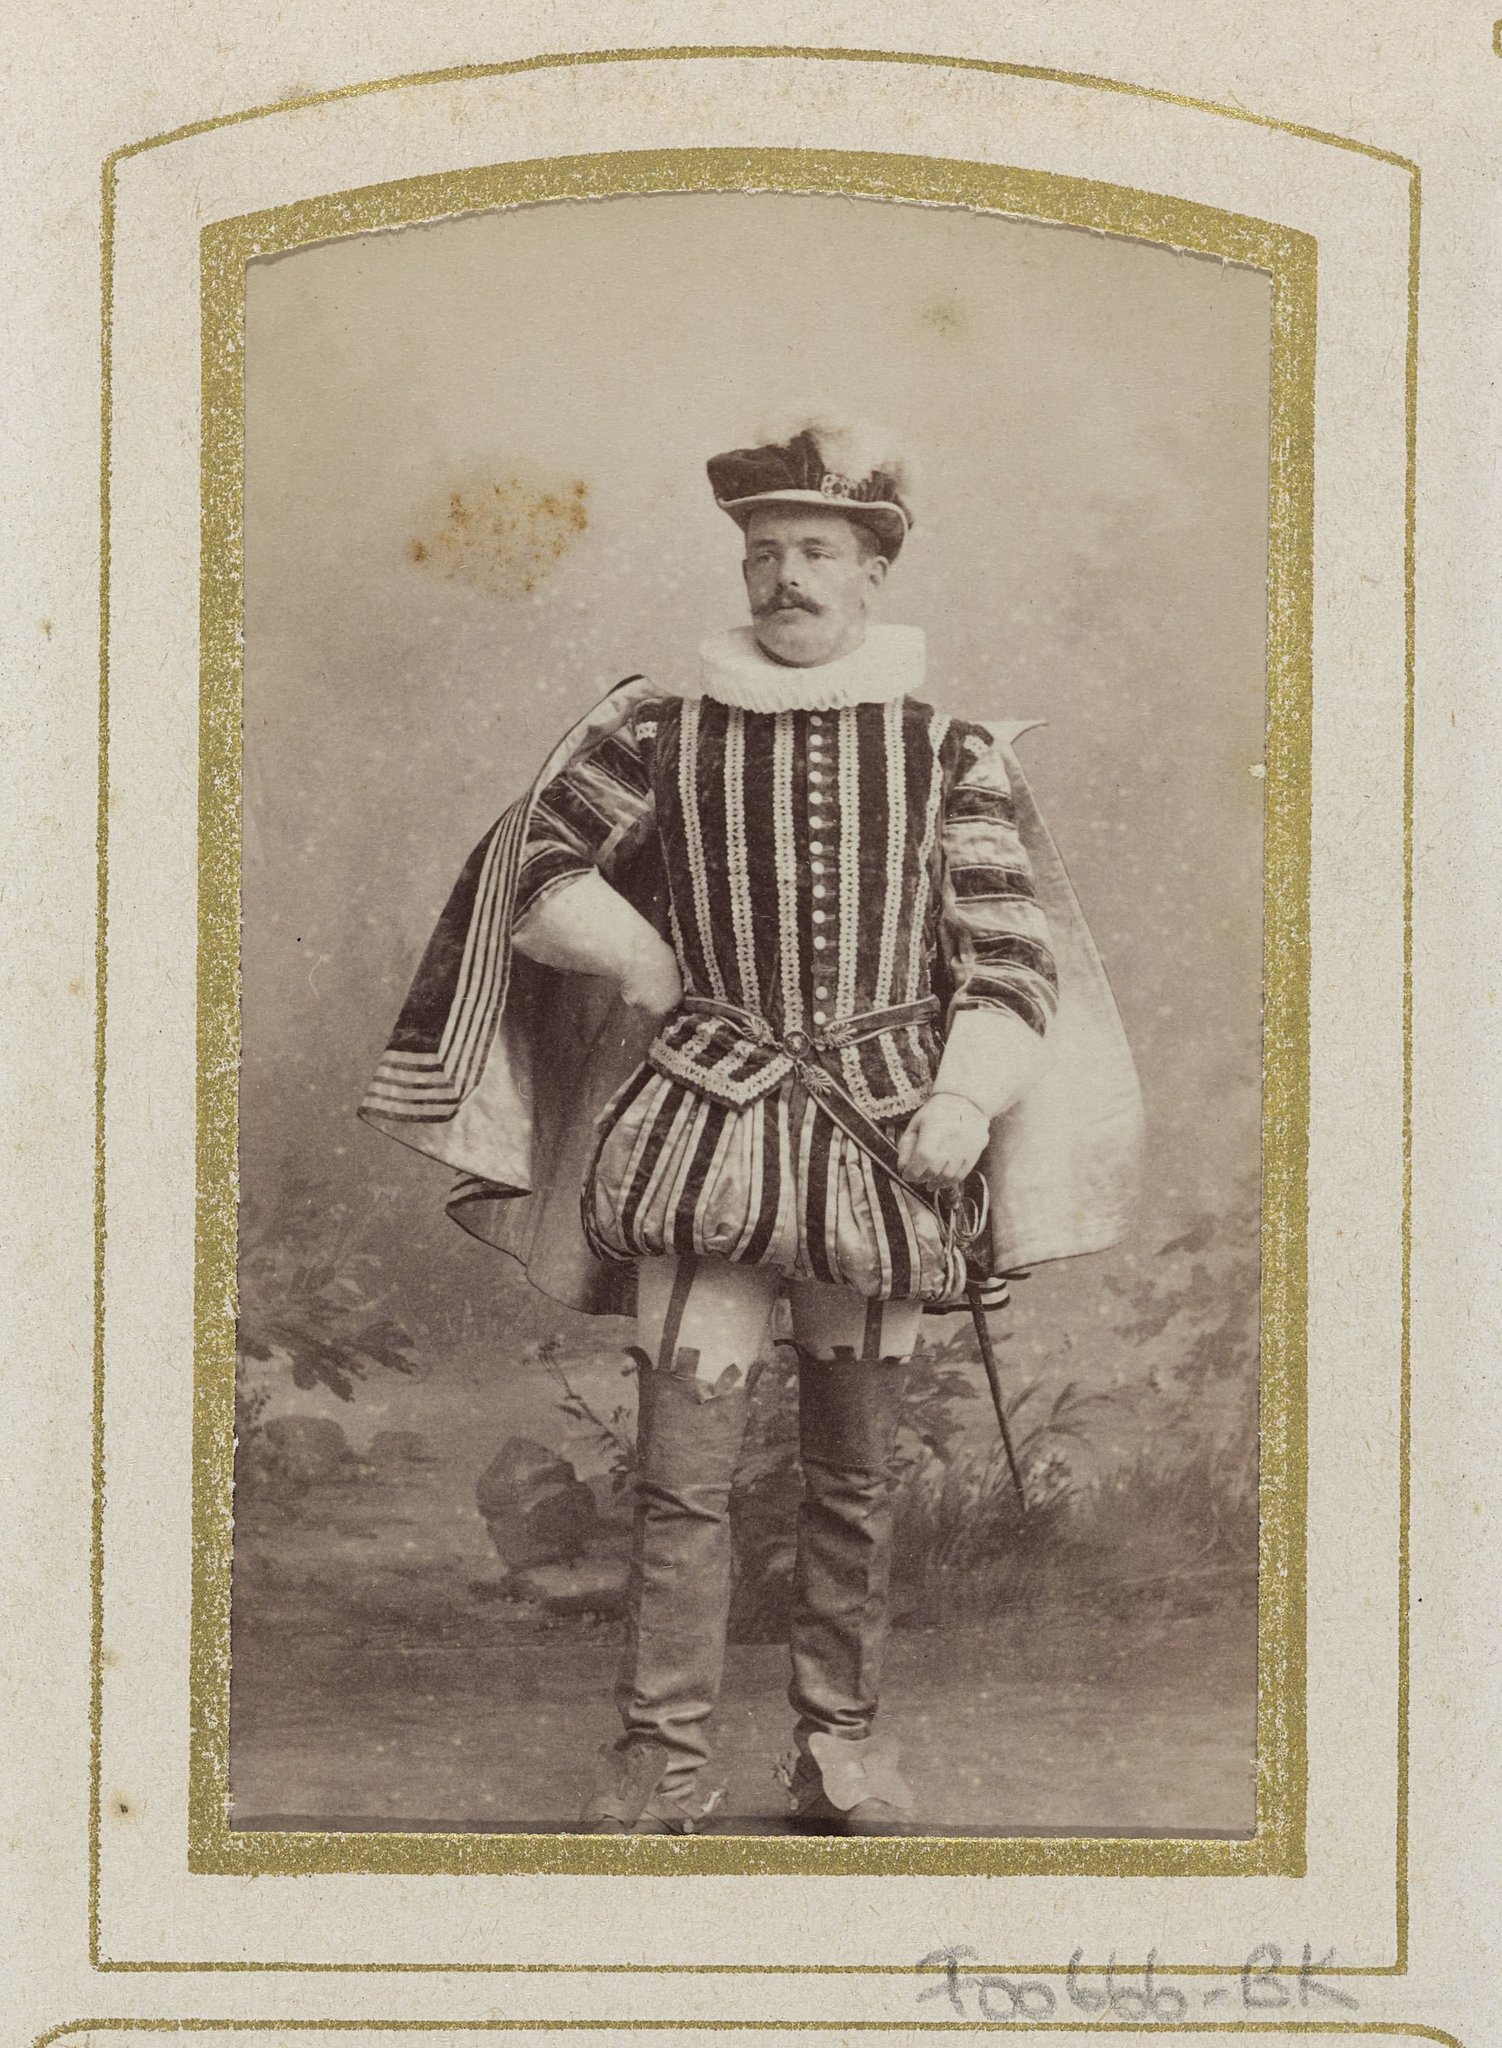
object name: album leaf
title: Portret van een man in kostuum met degen, aangeduid als J. Harmens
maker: antonius joannes van der stok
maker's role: fotograaf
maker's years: 1862-1941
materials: cardboard, photographic support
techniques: albumen print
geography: leiden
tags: historical persons, historical costume, hacking and thrusting weapons: rapier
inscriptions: inscription: ‘Ant. J. van der Stok/ PHOTOGRAPHE/ Leiden Rapenburg 13.’, name: ‘J. Harmens/ 92.’